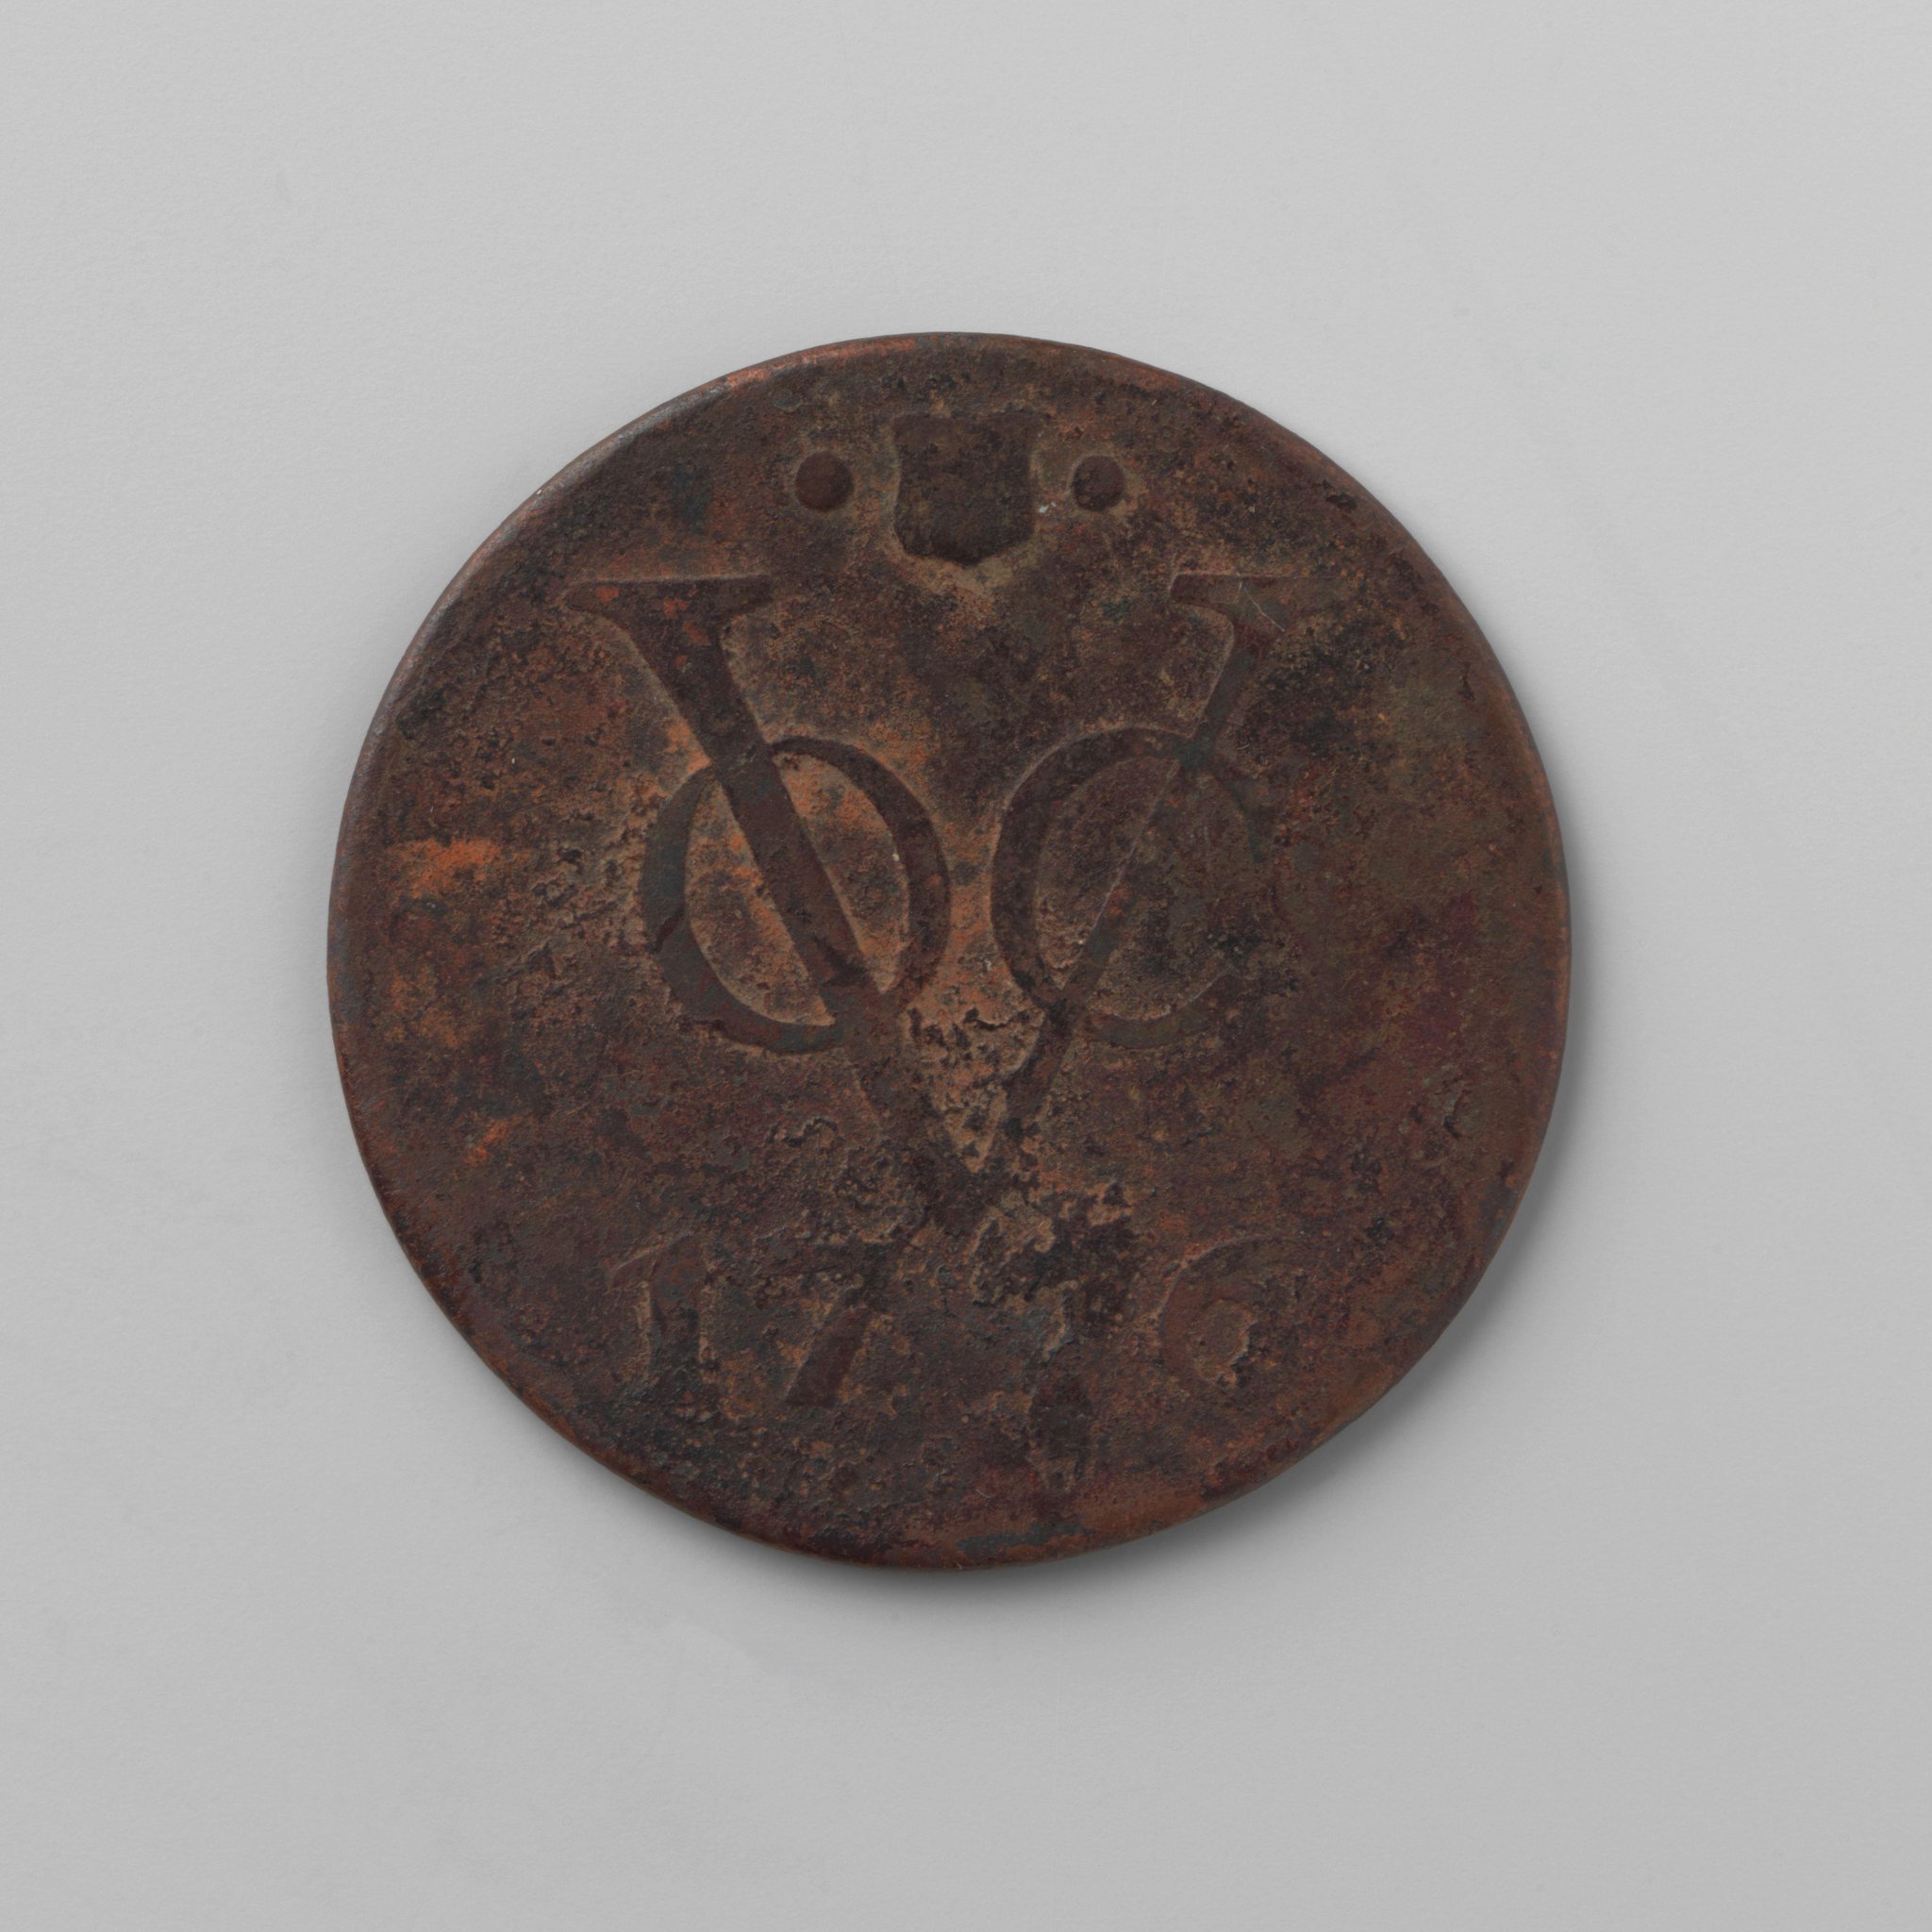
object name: coin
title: VOC, duit stad Utrecht,1776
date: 1776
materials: copper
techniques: striking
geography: utrecht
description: Koperen munt. Voorzijde: op balk, waaronder guirlande, geplaatst, door twee leeuwen gehouden gekroond wapenschild van de stad Utrecht. Keerzijde: monogram van de VOC, waarboven muntteken en waaronder jaartal. Gladde rand.